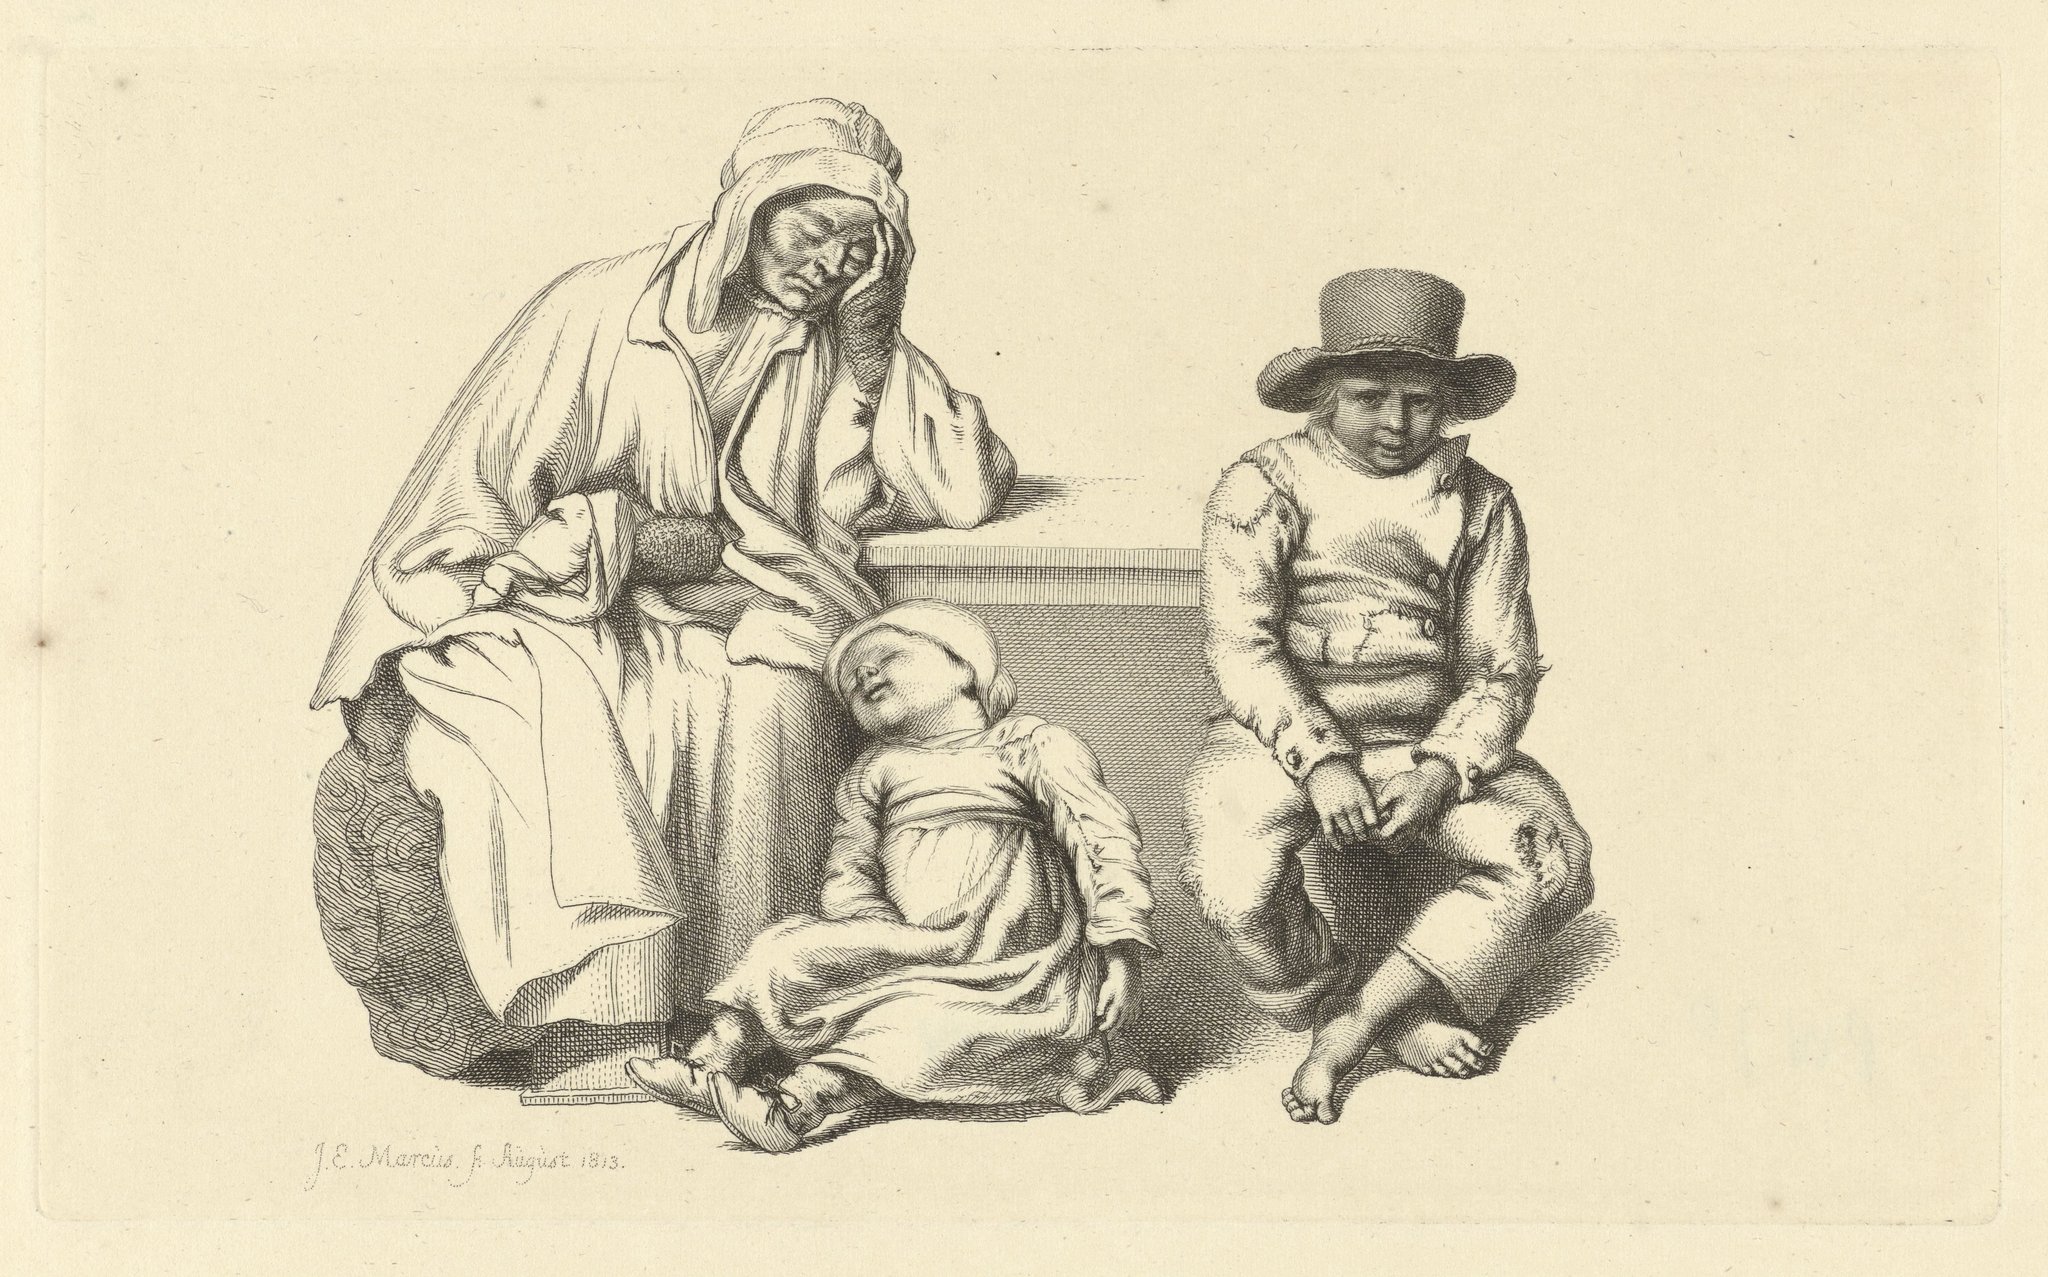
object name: print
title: Studie-prentwerk / Etudes gravées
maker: jacob ernst marcus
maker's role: draughtsman, print maker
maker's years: 1774-1826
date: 1808-1813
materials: paper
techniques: etching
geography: amsterdam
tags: child, old woman, sleeping; unconsciousness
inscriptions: collector's mark: Lugt 2228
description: Serie voor het eerst uitgegeven door Jacob Ernst Marcus onder de titel Studiebeelden en Fragmenten. Amsterdam: ca.1816. Later heruitgegeven als: Studie-prentwerk/ Etudes gravées.